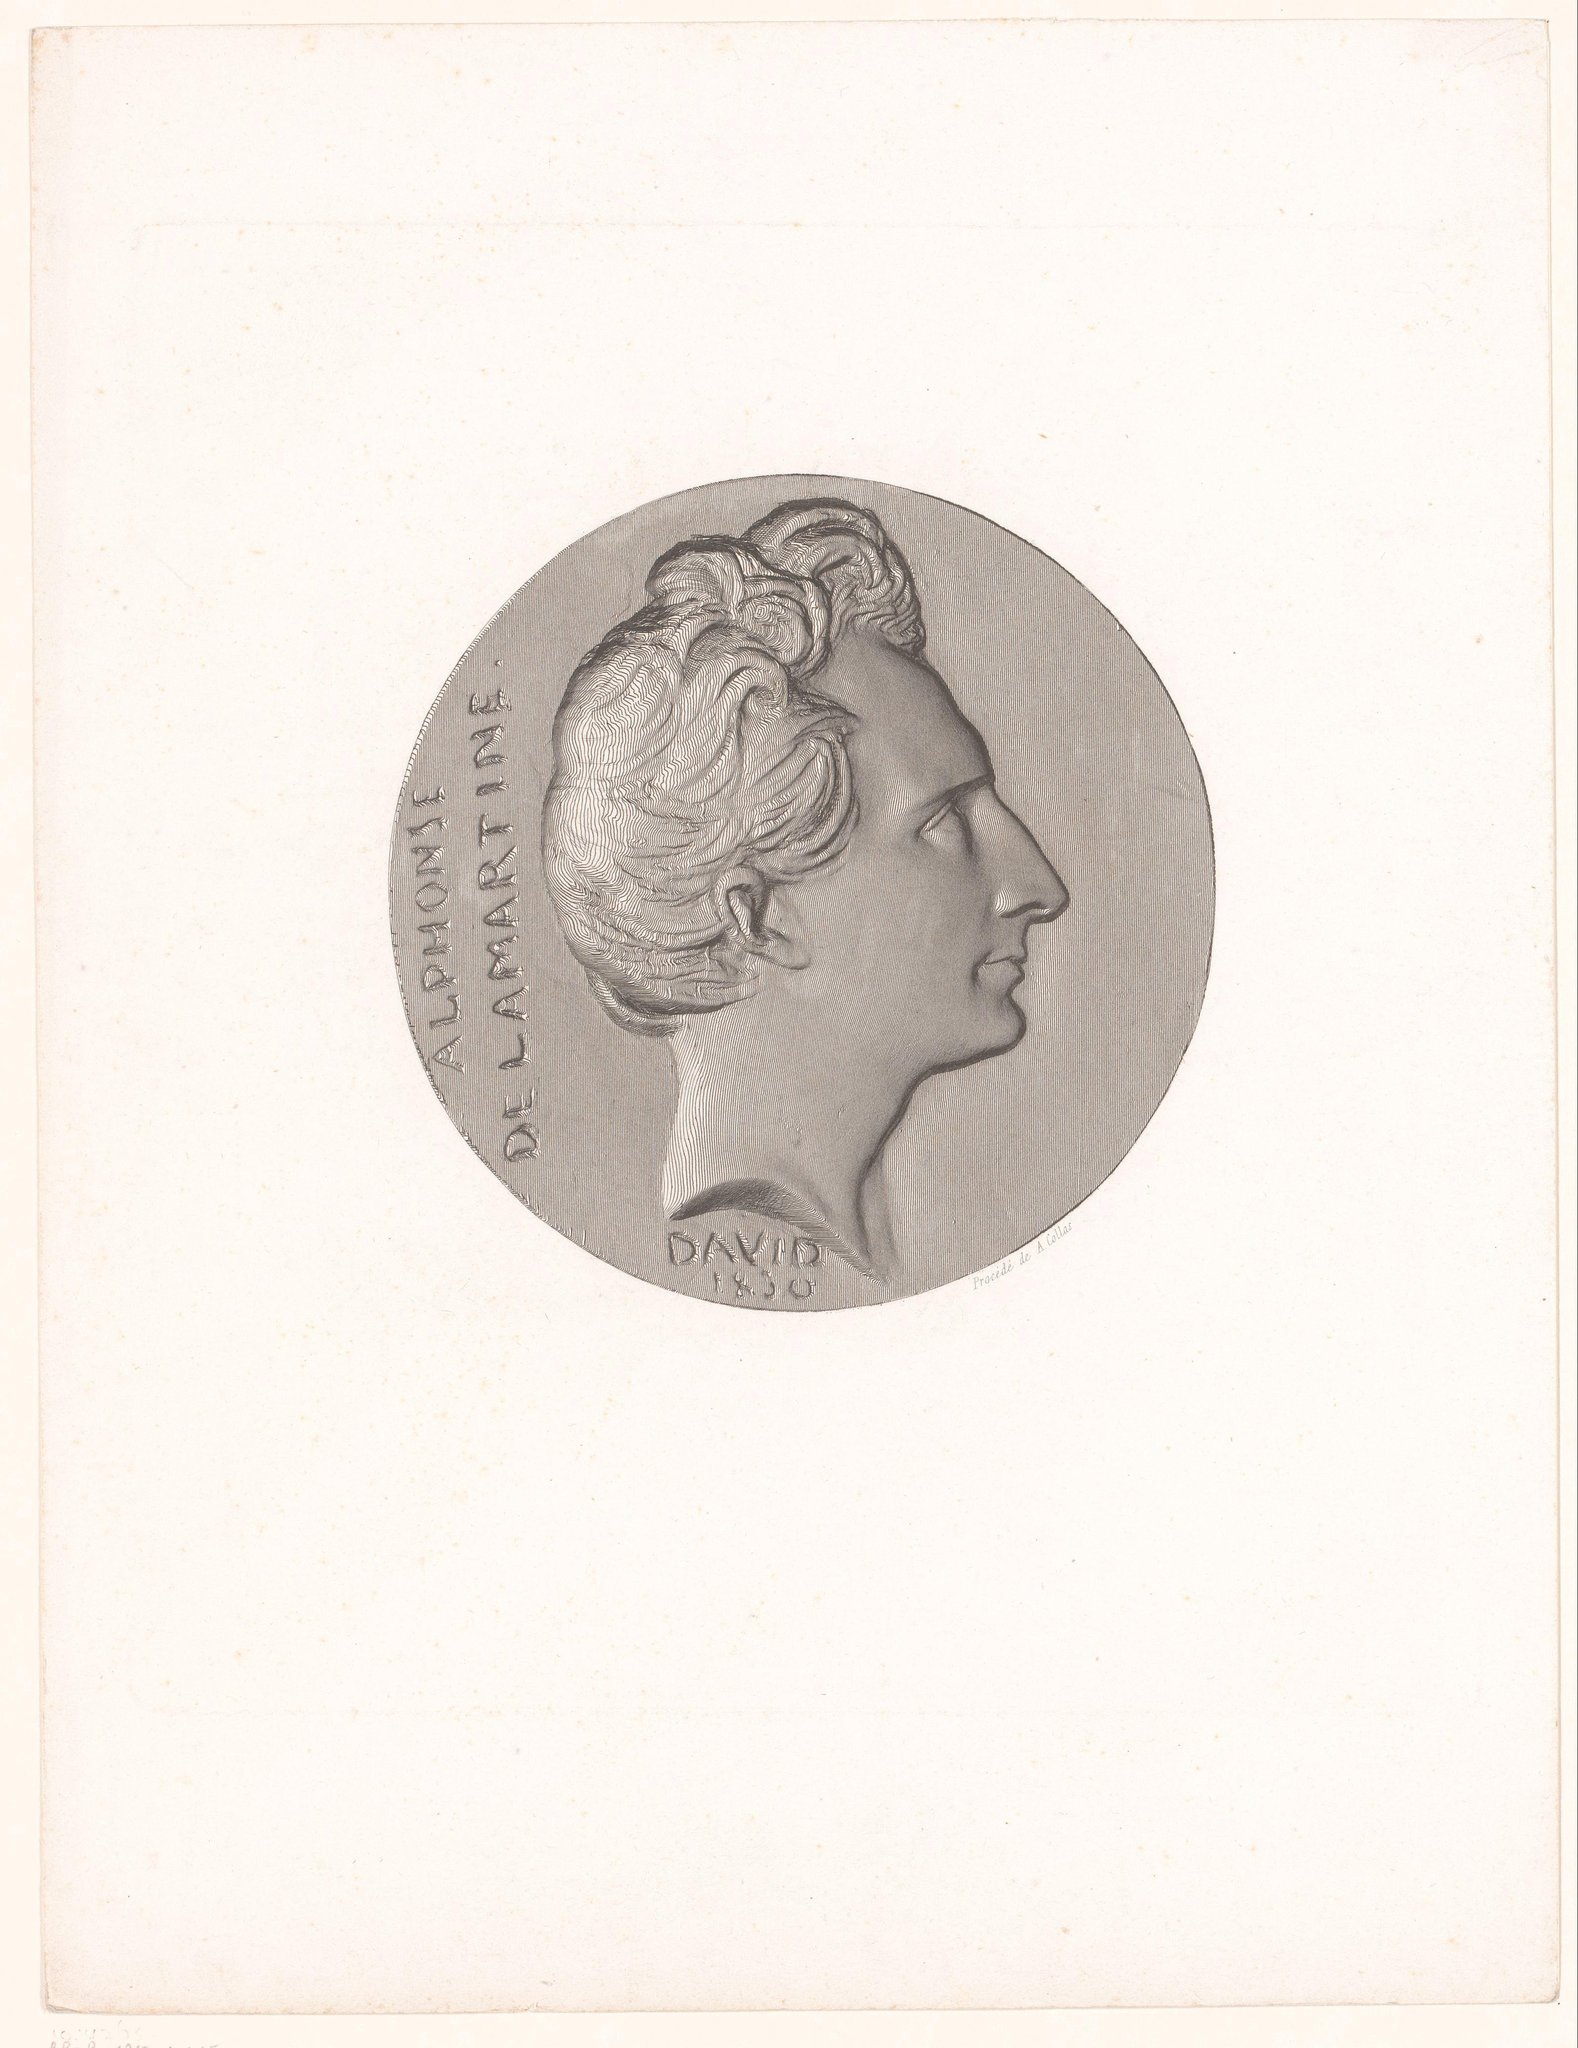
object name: print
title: Serie medaillons met vooraanstaande figuren uit het begin van de negentiende eeuw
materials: paper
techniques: relief engraving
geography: france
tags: paris, ornament ~ medallion, historical persons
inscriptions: collector's mark: Lugt 2228